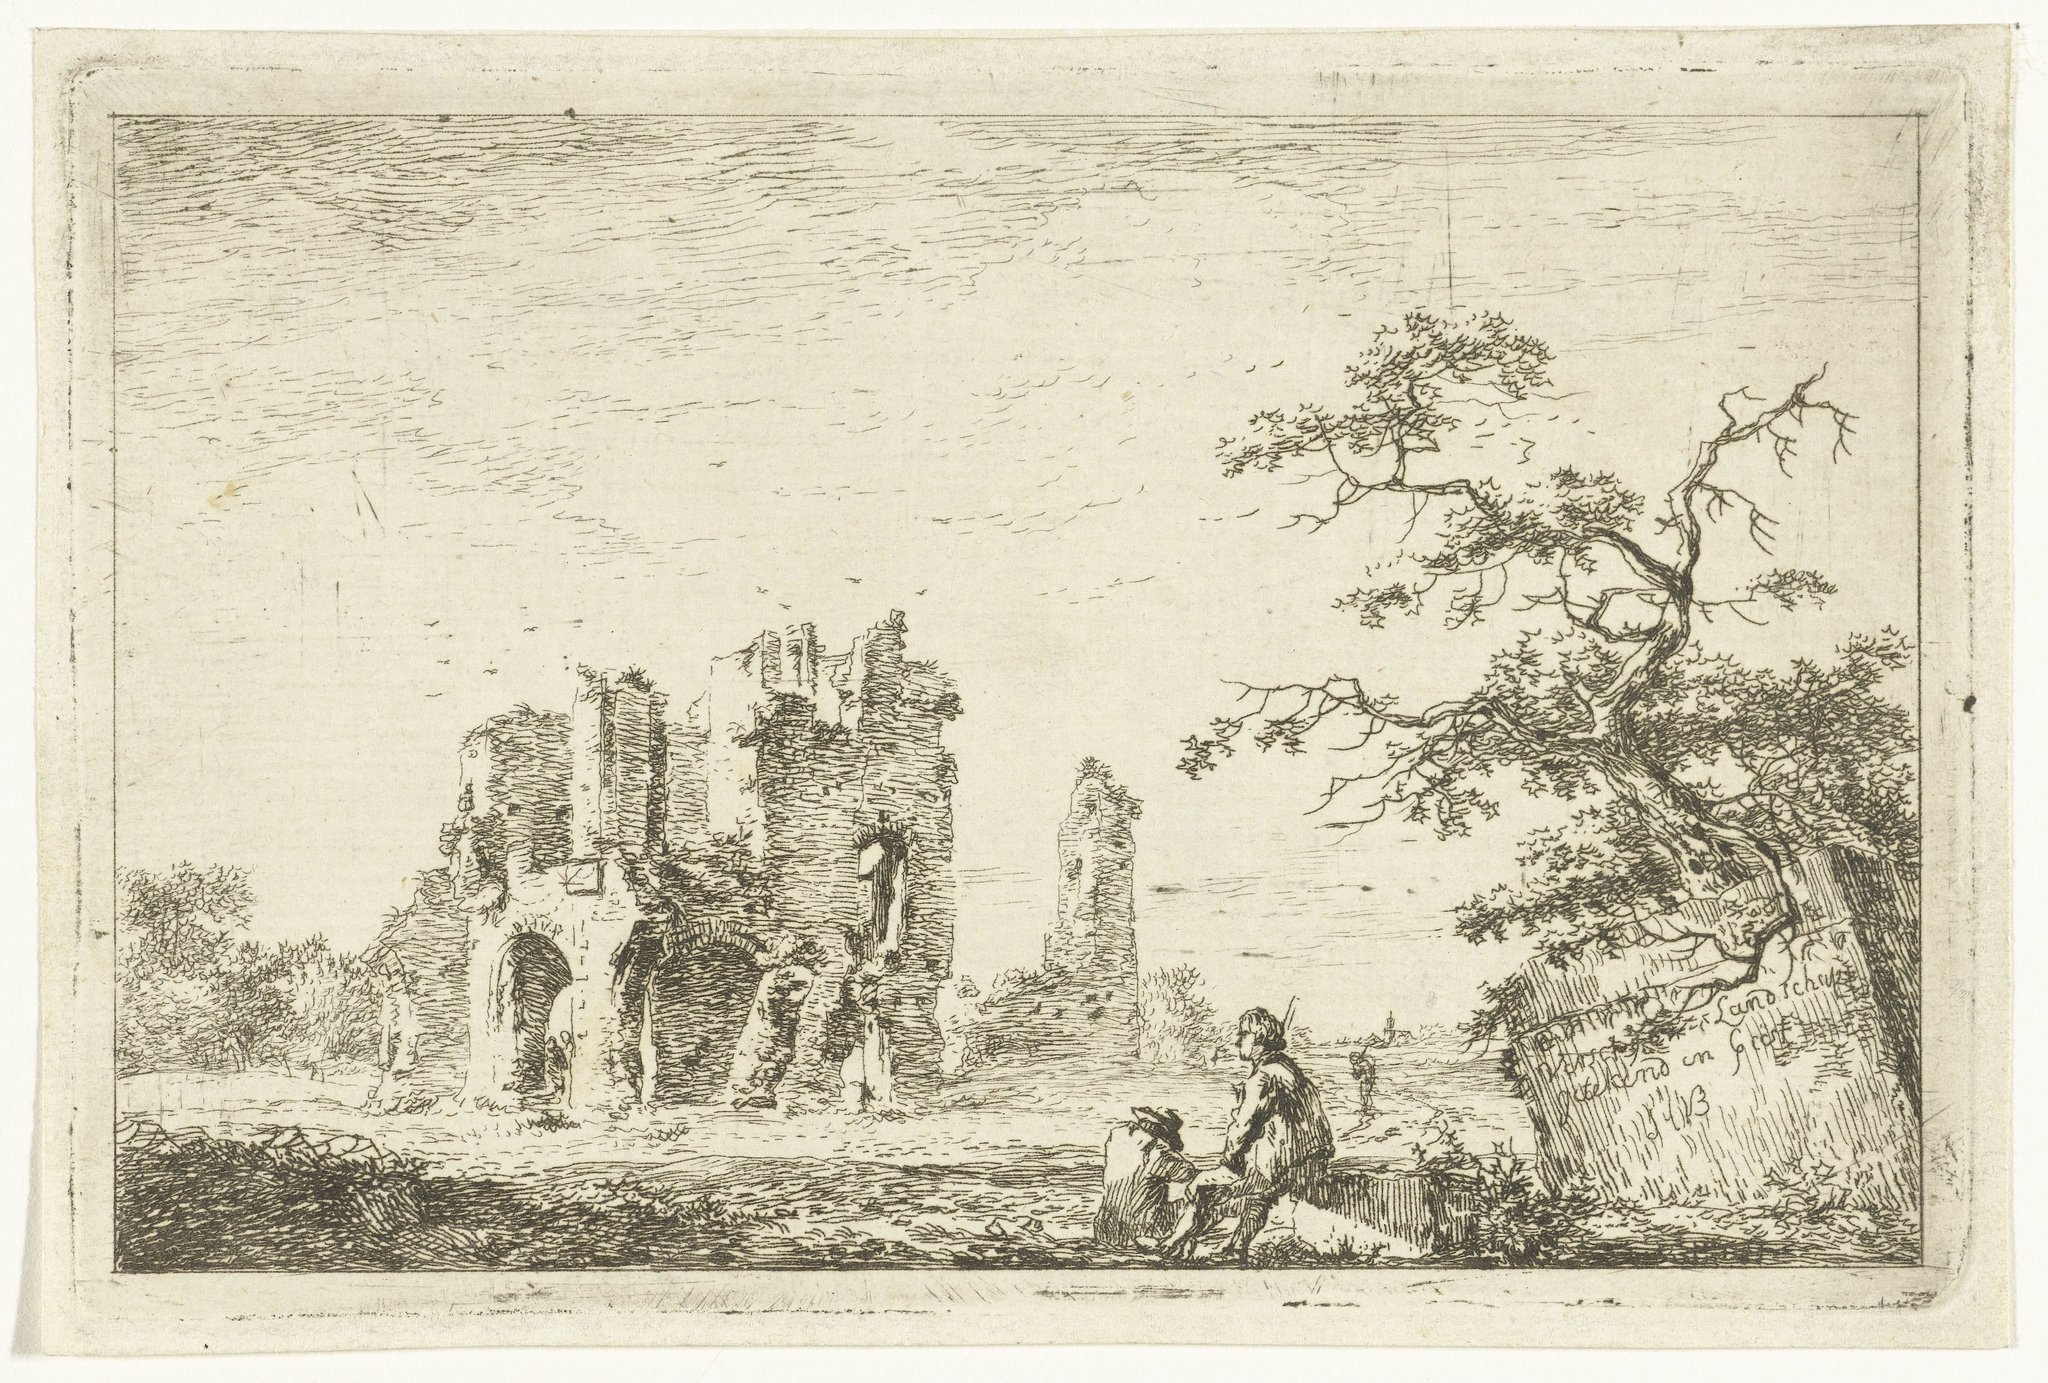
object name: print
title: Ruïne van Rijnsburg, gezien vanuit het zuidwesten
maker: hermanus van brussel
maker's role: draughtsman, print maker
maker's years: 1763-1815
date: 1800-1815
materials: paper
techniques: etching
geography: netherlands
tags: landscapes in the temperate zone, ruin of church, monastery, etc.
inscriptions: collector's mark: Lugt 2228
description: Ontwerptekening aanwezig in de collectie van het Rijksmuseum Amsterdam, inv. nr. RP-T-1894-A-2836.